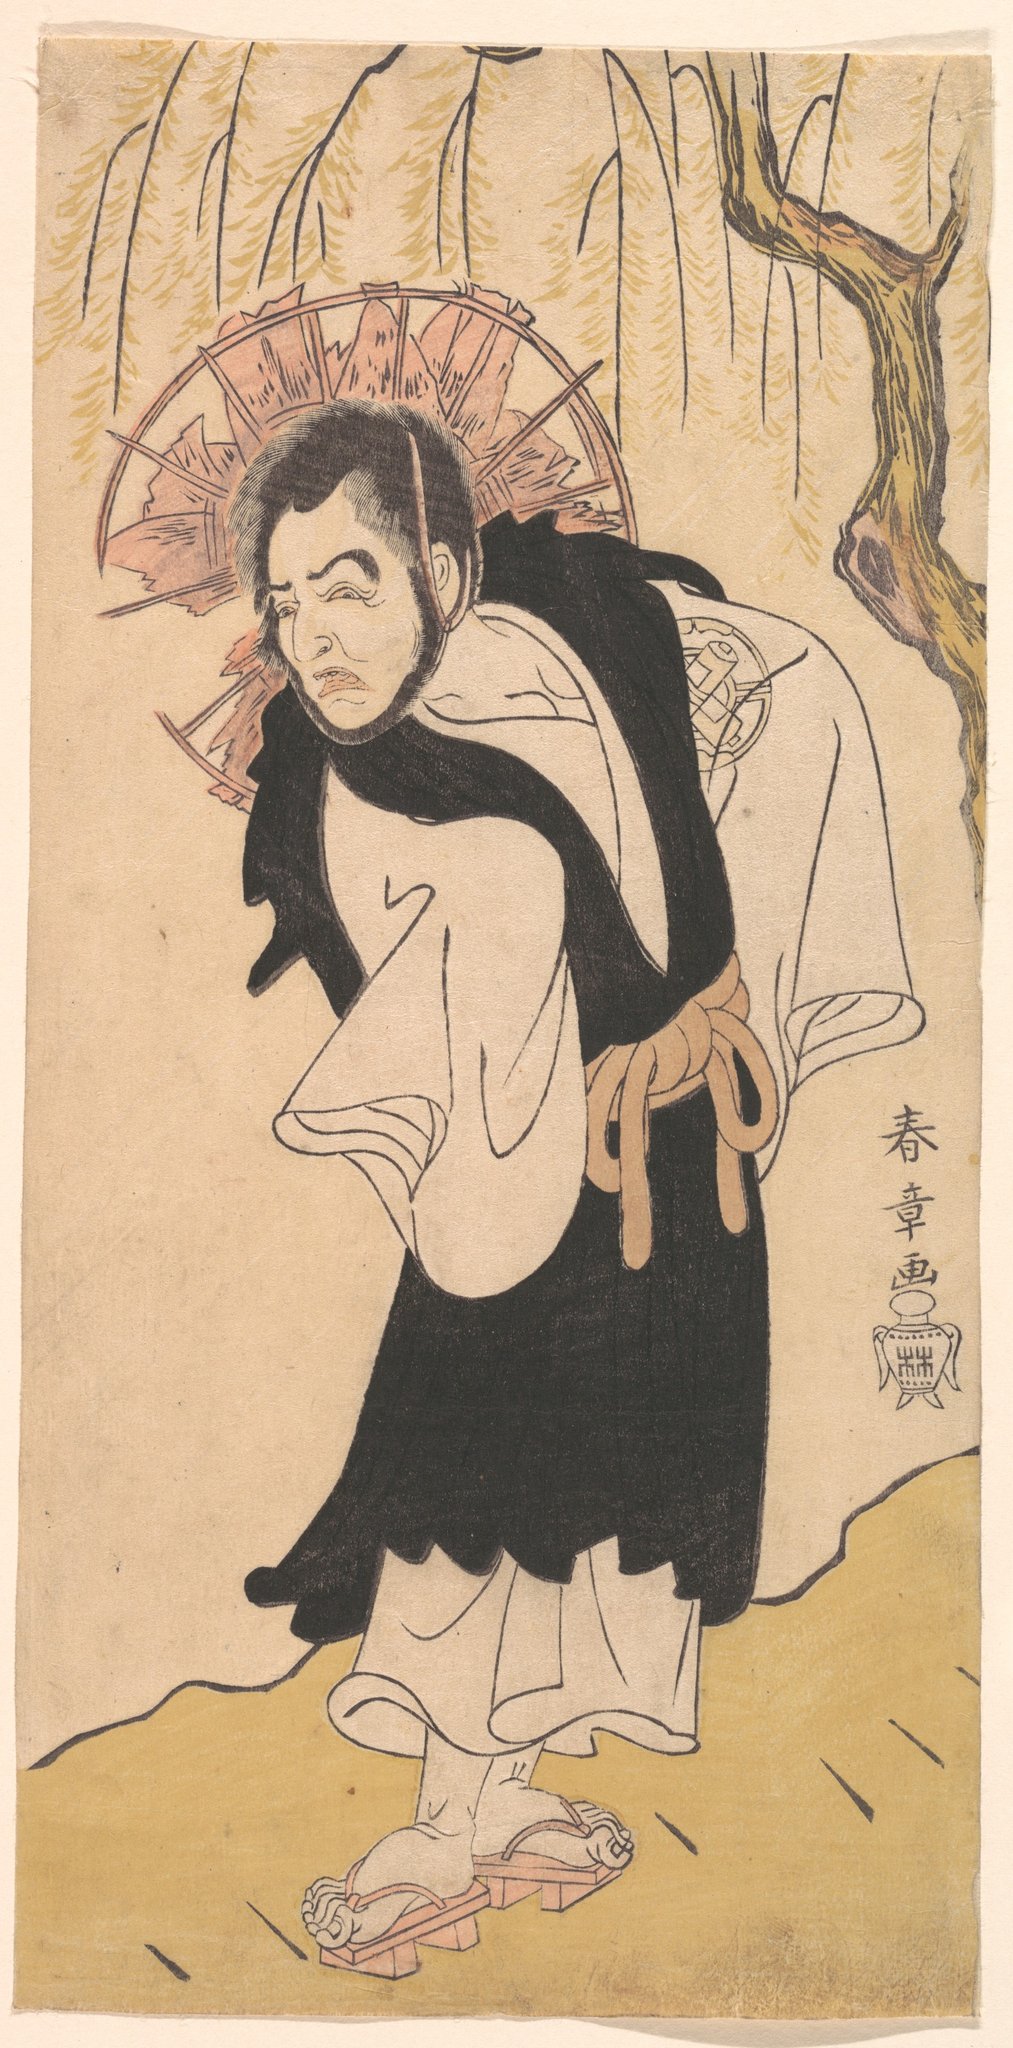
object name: woodblock print nishiki e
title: The Actor Nakamura Utaemon I as a Monk under a Willow Tree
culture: japanese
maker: katsukawa shunshō 勝川春章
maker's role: artist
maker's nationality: japanese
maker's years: 1726-1792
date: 1726-1792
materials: ink, paper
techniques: nishiki e, woodblock print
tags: men,trees,actors